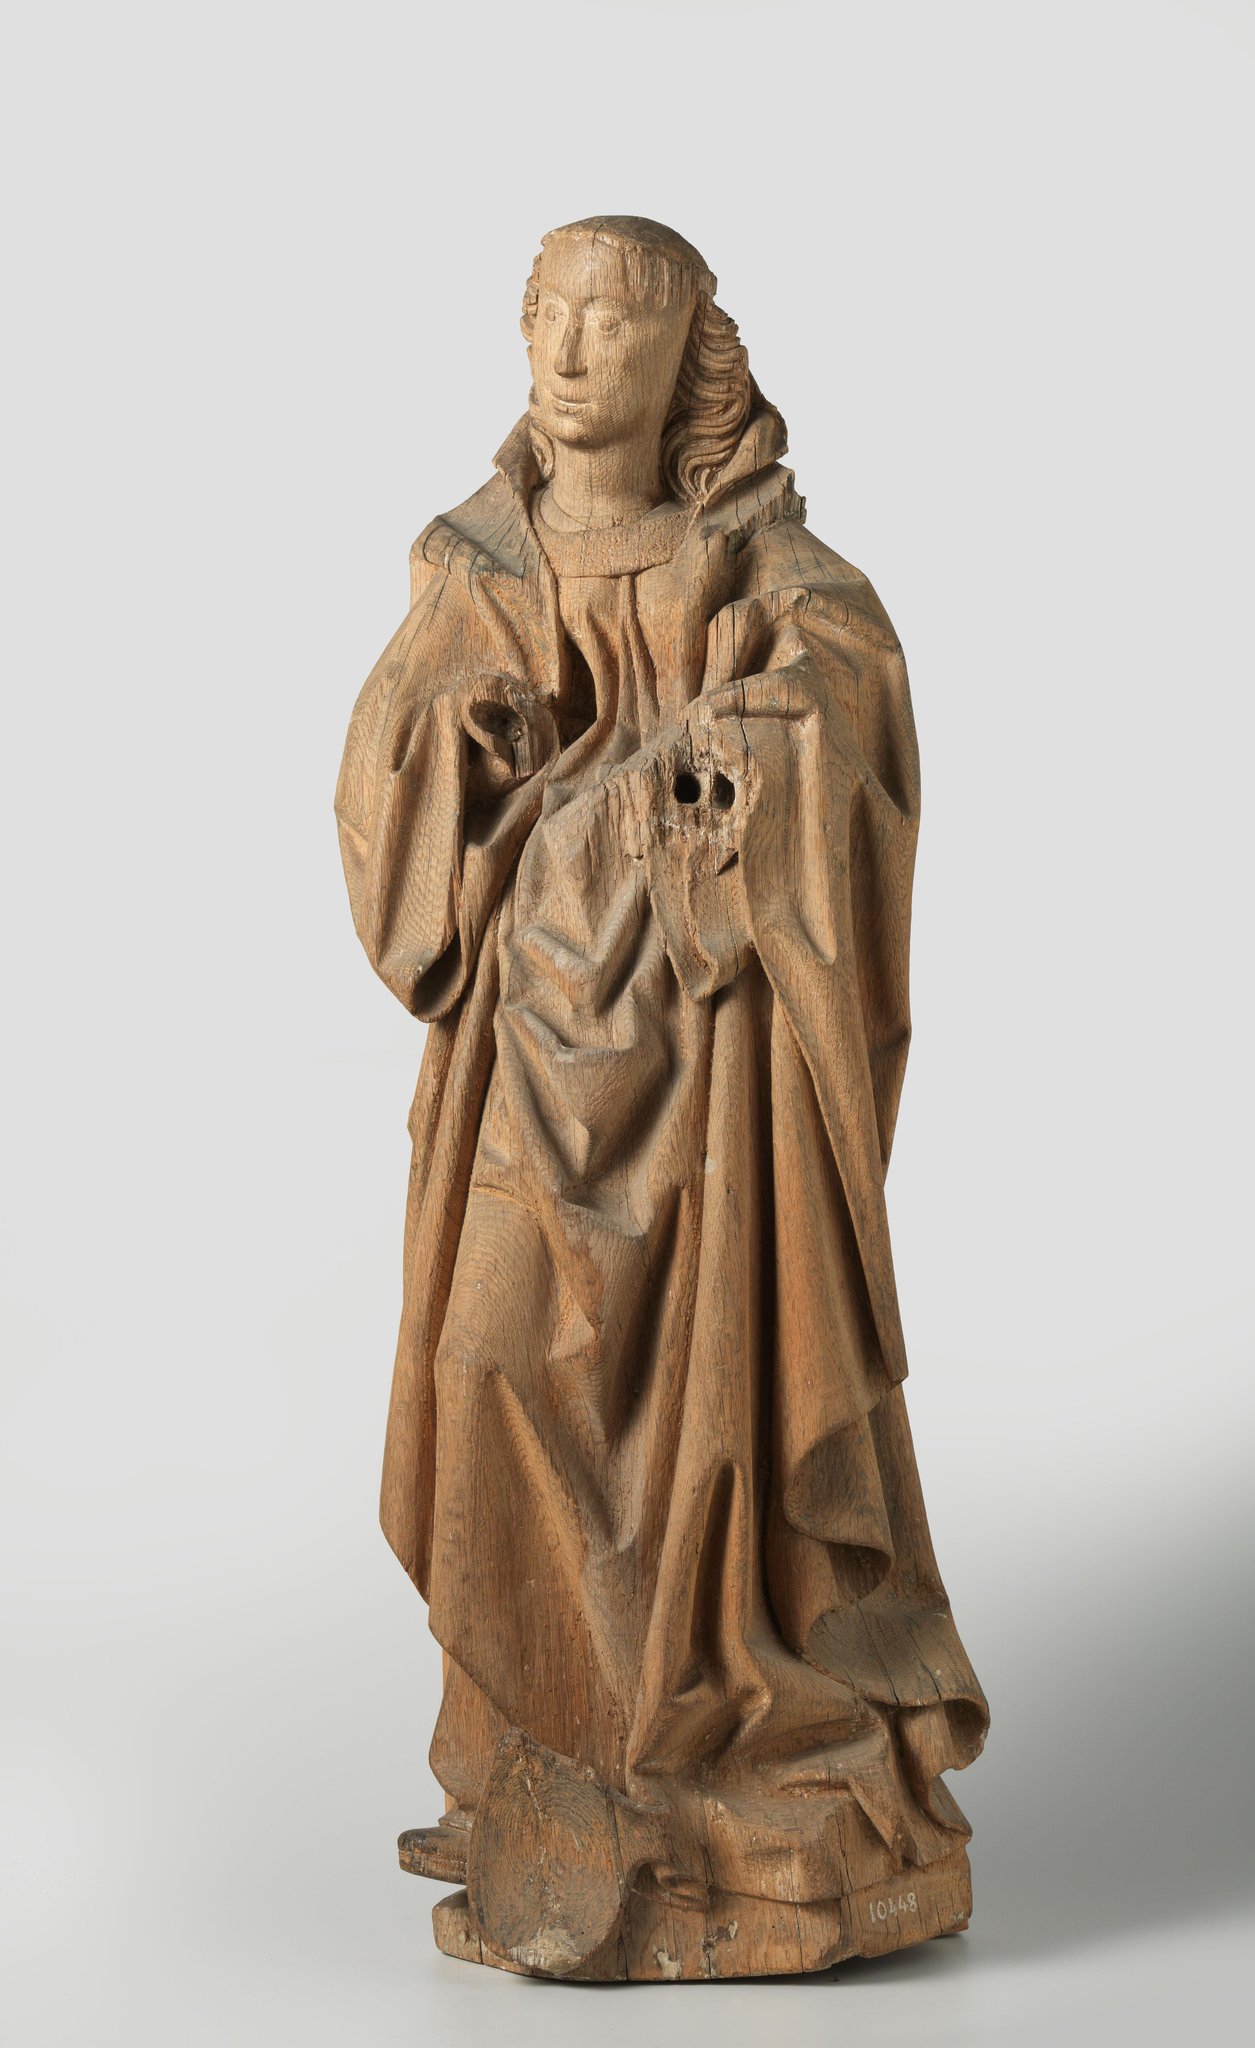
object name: sculpture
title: Female Saint (Virgin Mary?)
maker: Anonymous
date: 1500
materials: wood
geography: lower rhine region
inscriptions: coat of arms, on the escutheon at the figure's feet: removed